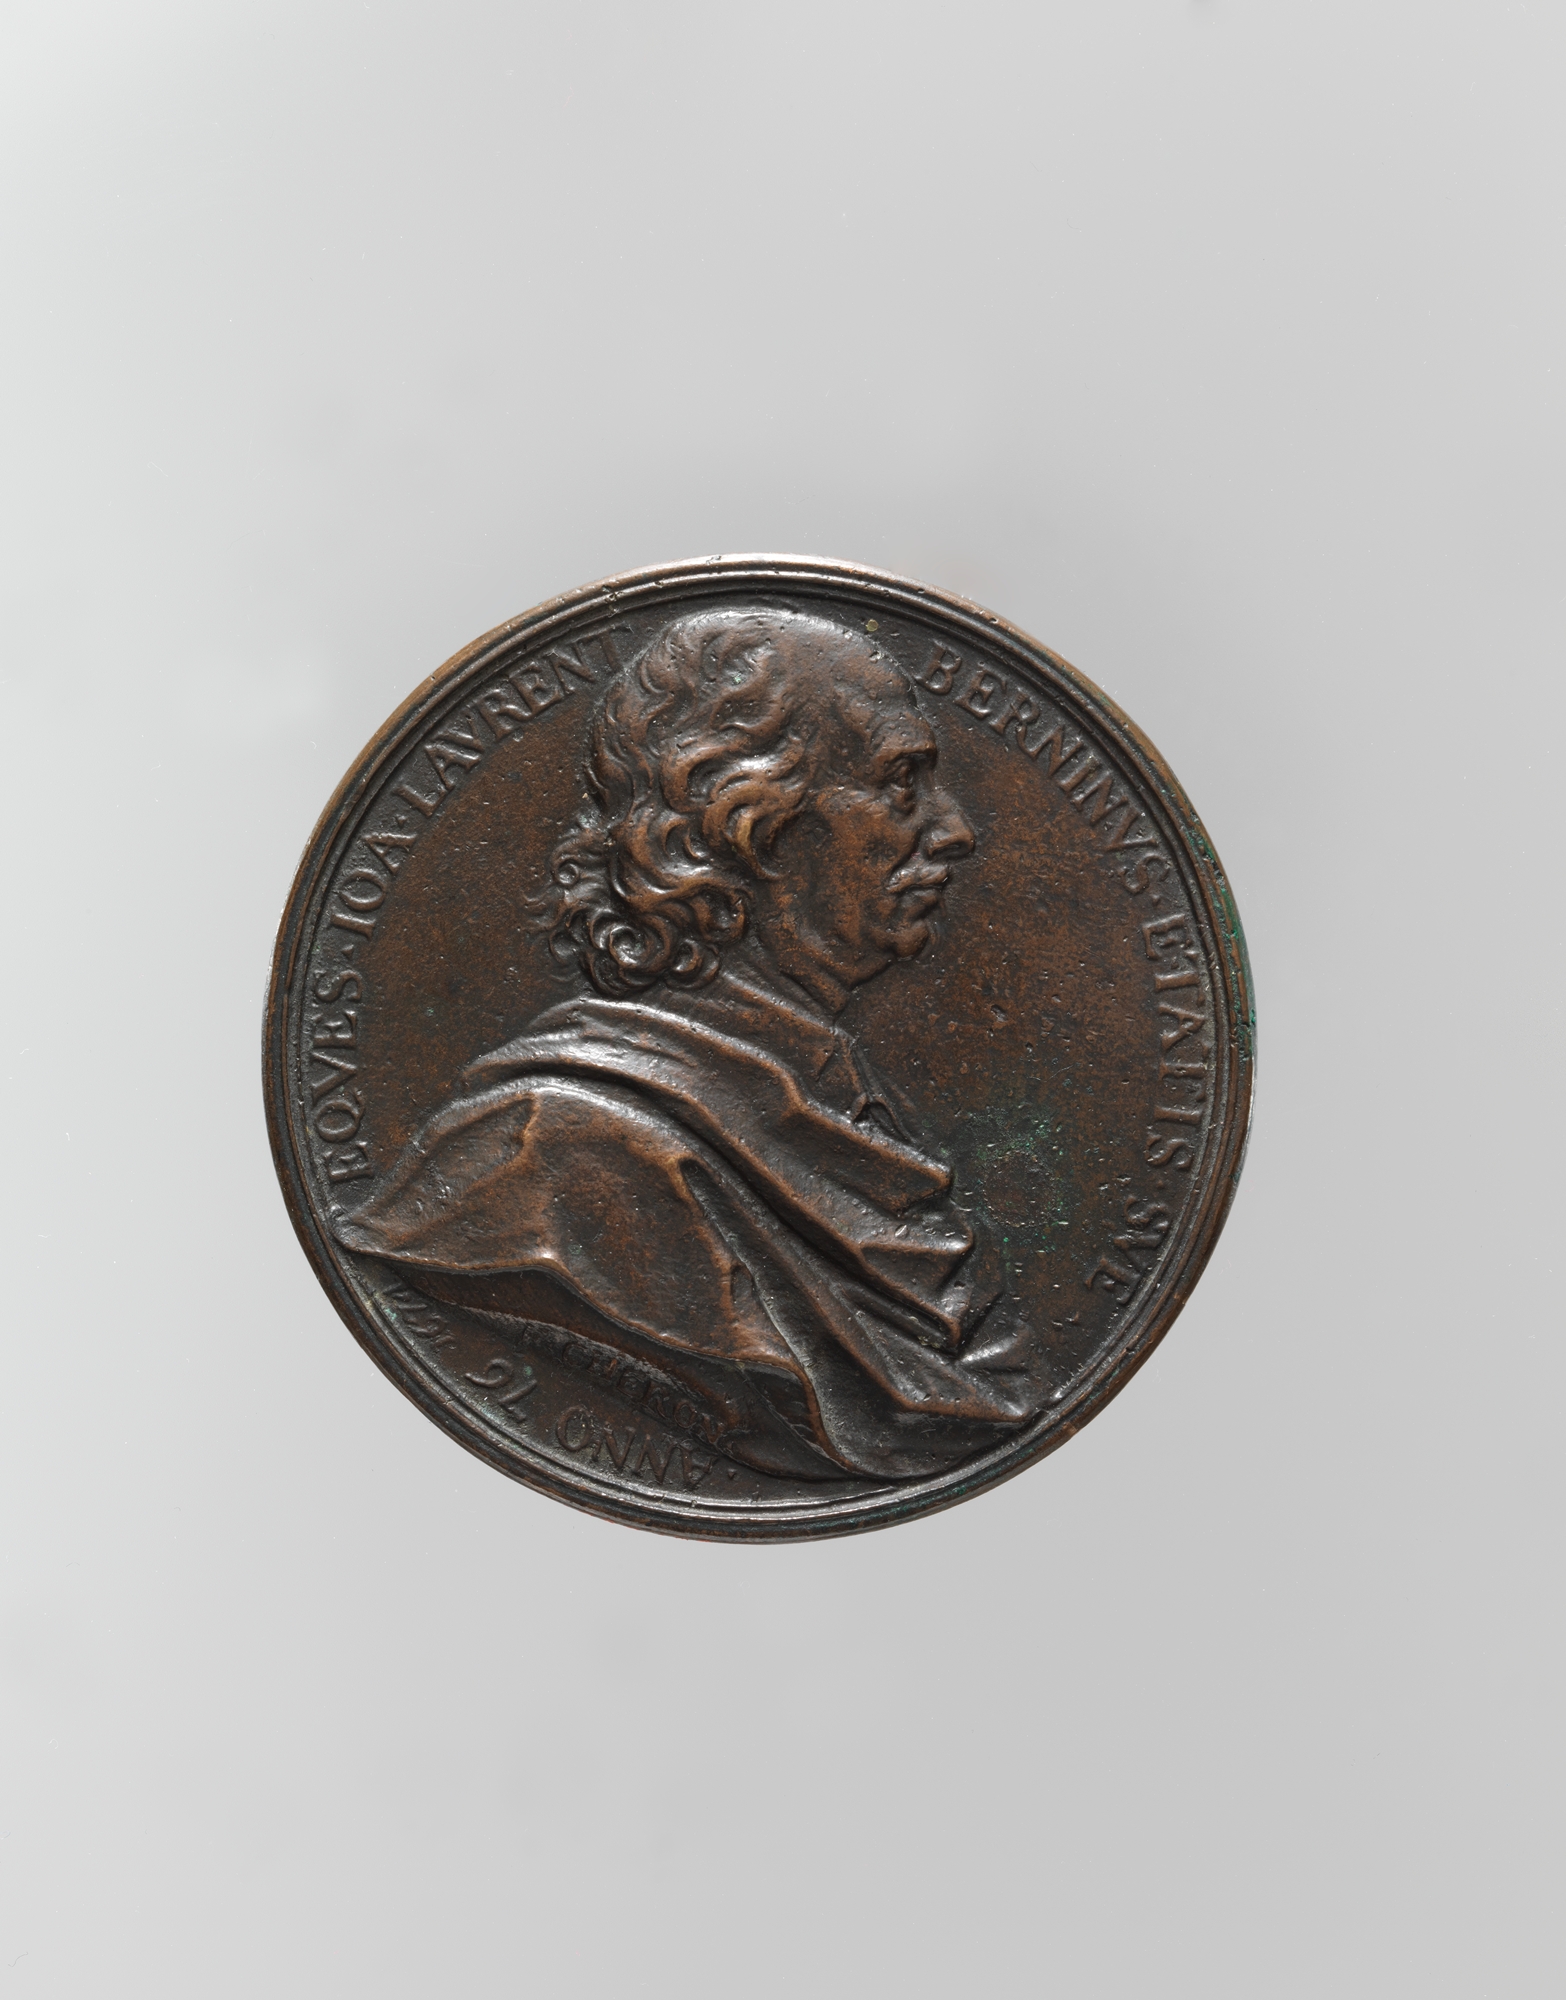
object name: medal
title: Gian Lorenzo Bernini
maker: françois chéron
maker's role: artist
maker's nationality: french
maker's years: 1635-1698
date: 1674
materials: bronze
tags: men,profiles